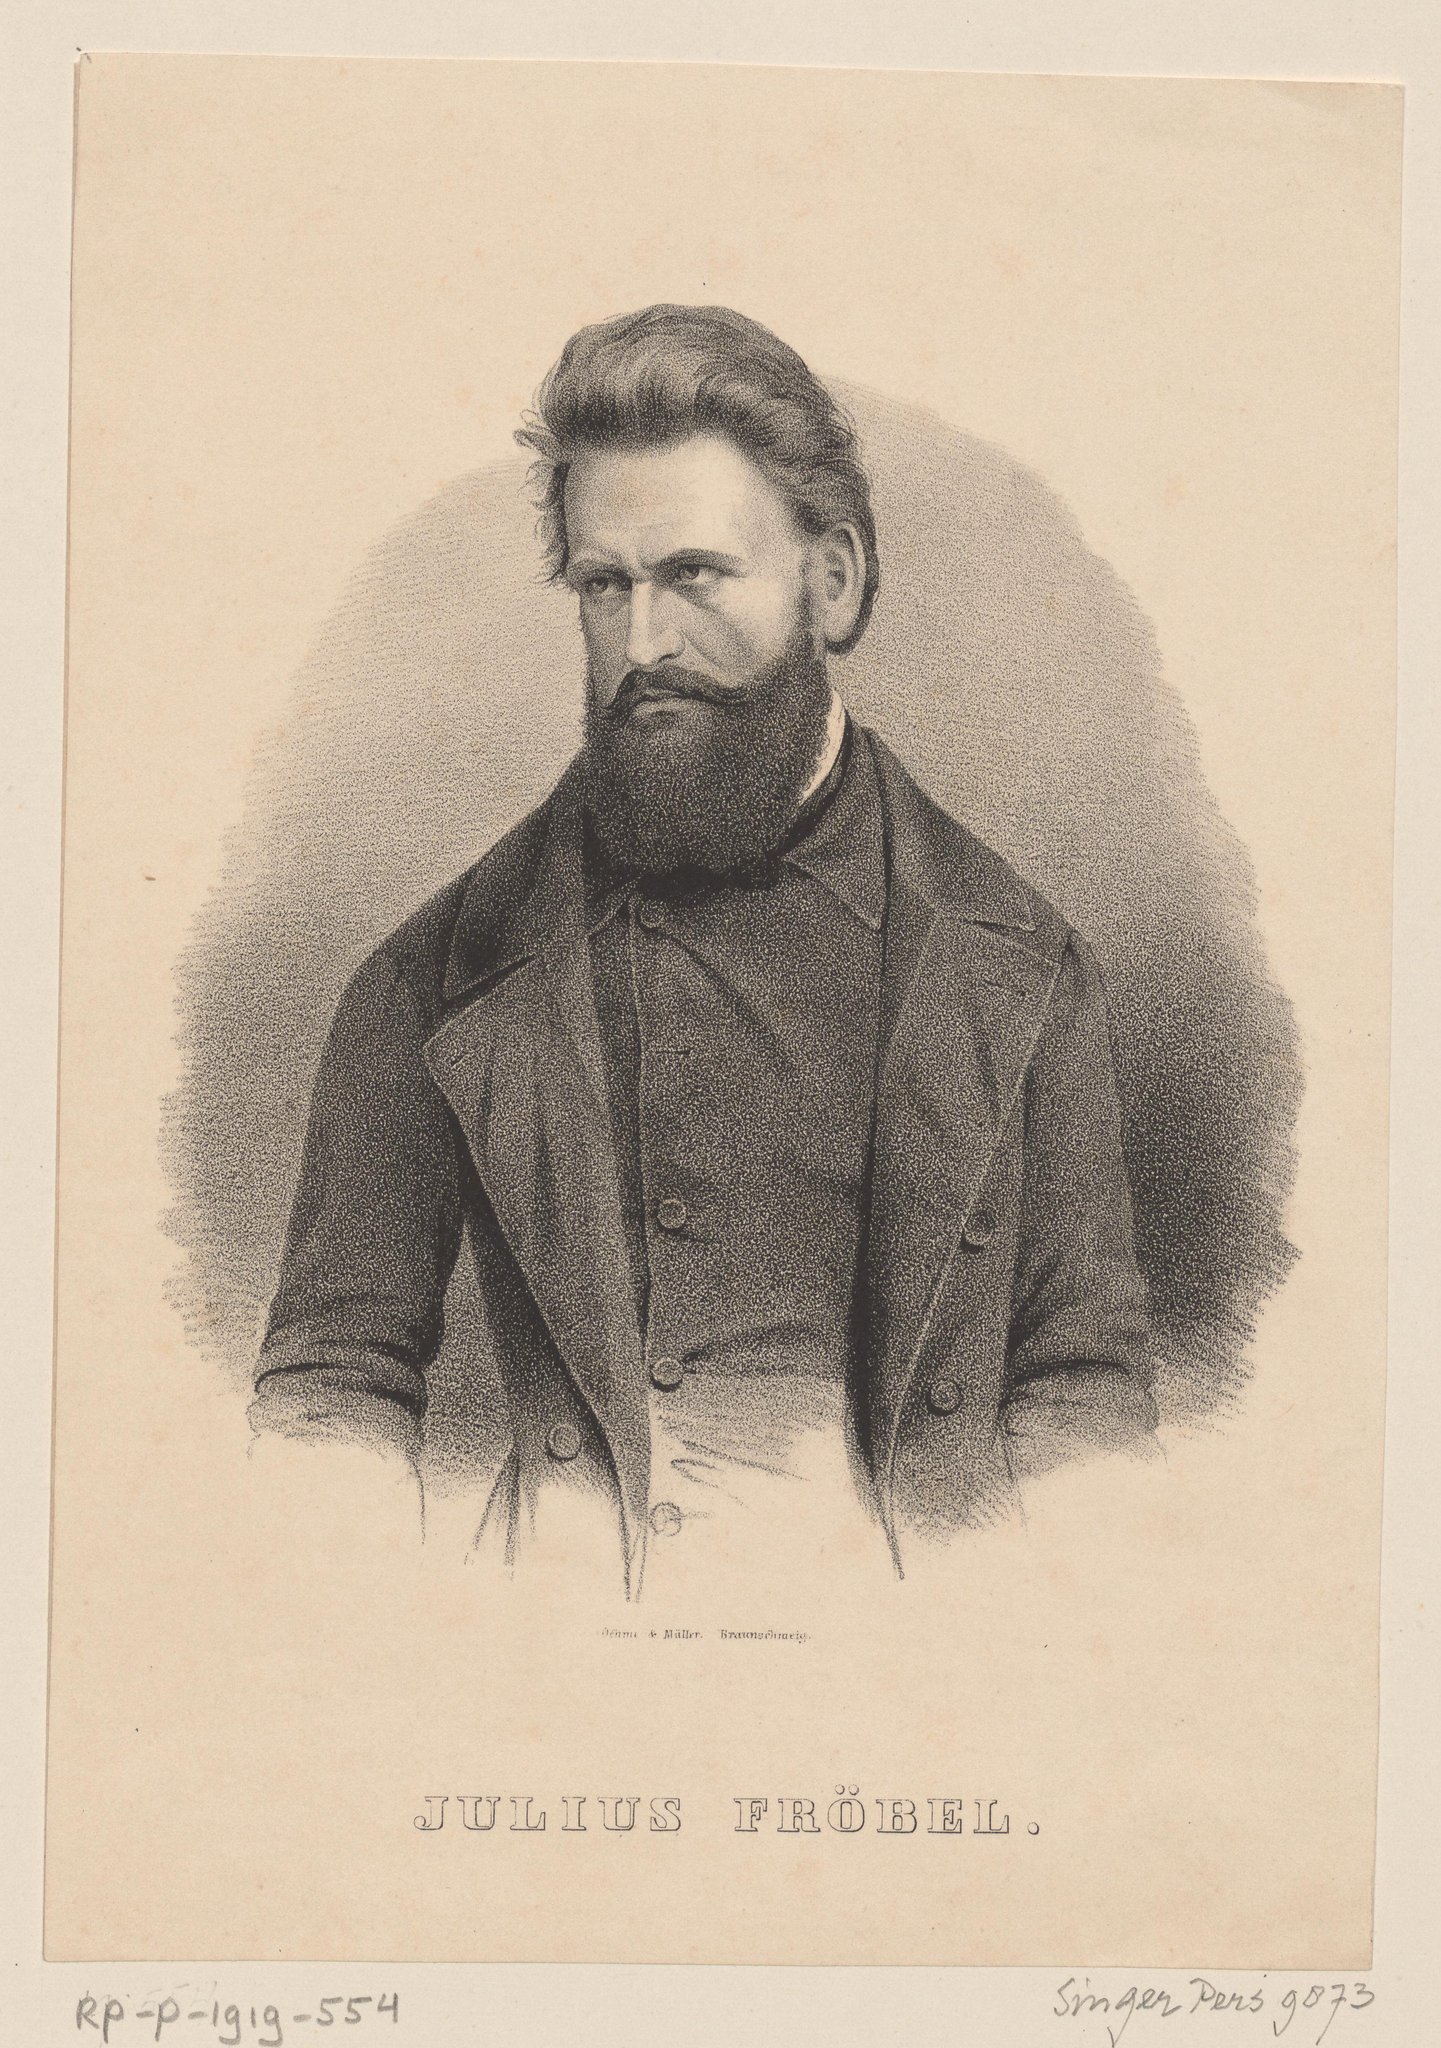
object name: print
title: Portret van Julius Fröbel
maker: Anonymous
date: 1835-1846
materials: paper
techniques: lithograph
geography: braunschweig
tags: politician, historical persons, politician, e.g. party leader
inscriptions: collector's mark: Lugt 2228